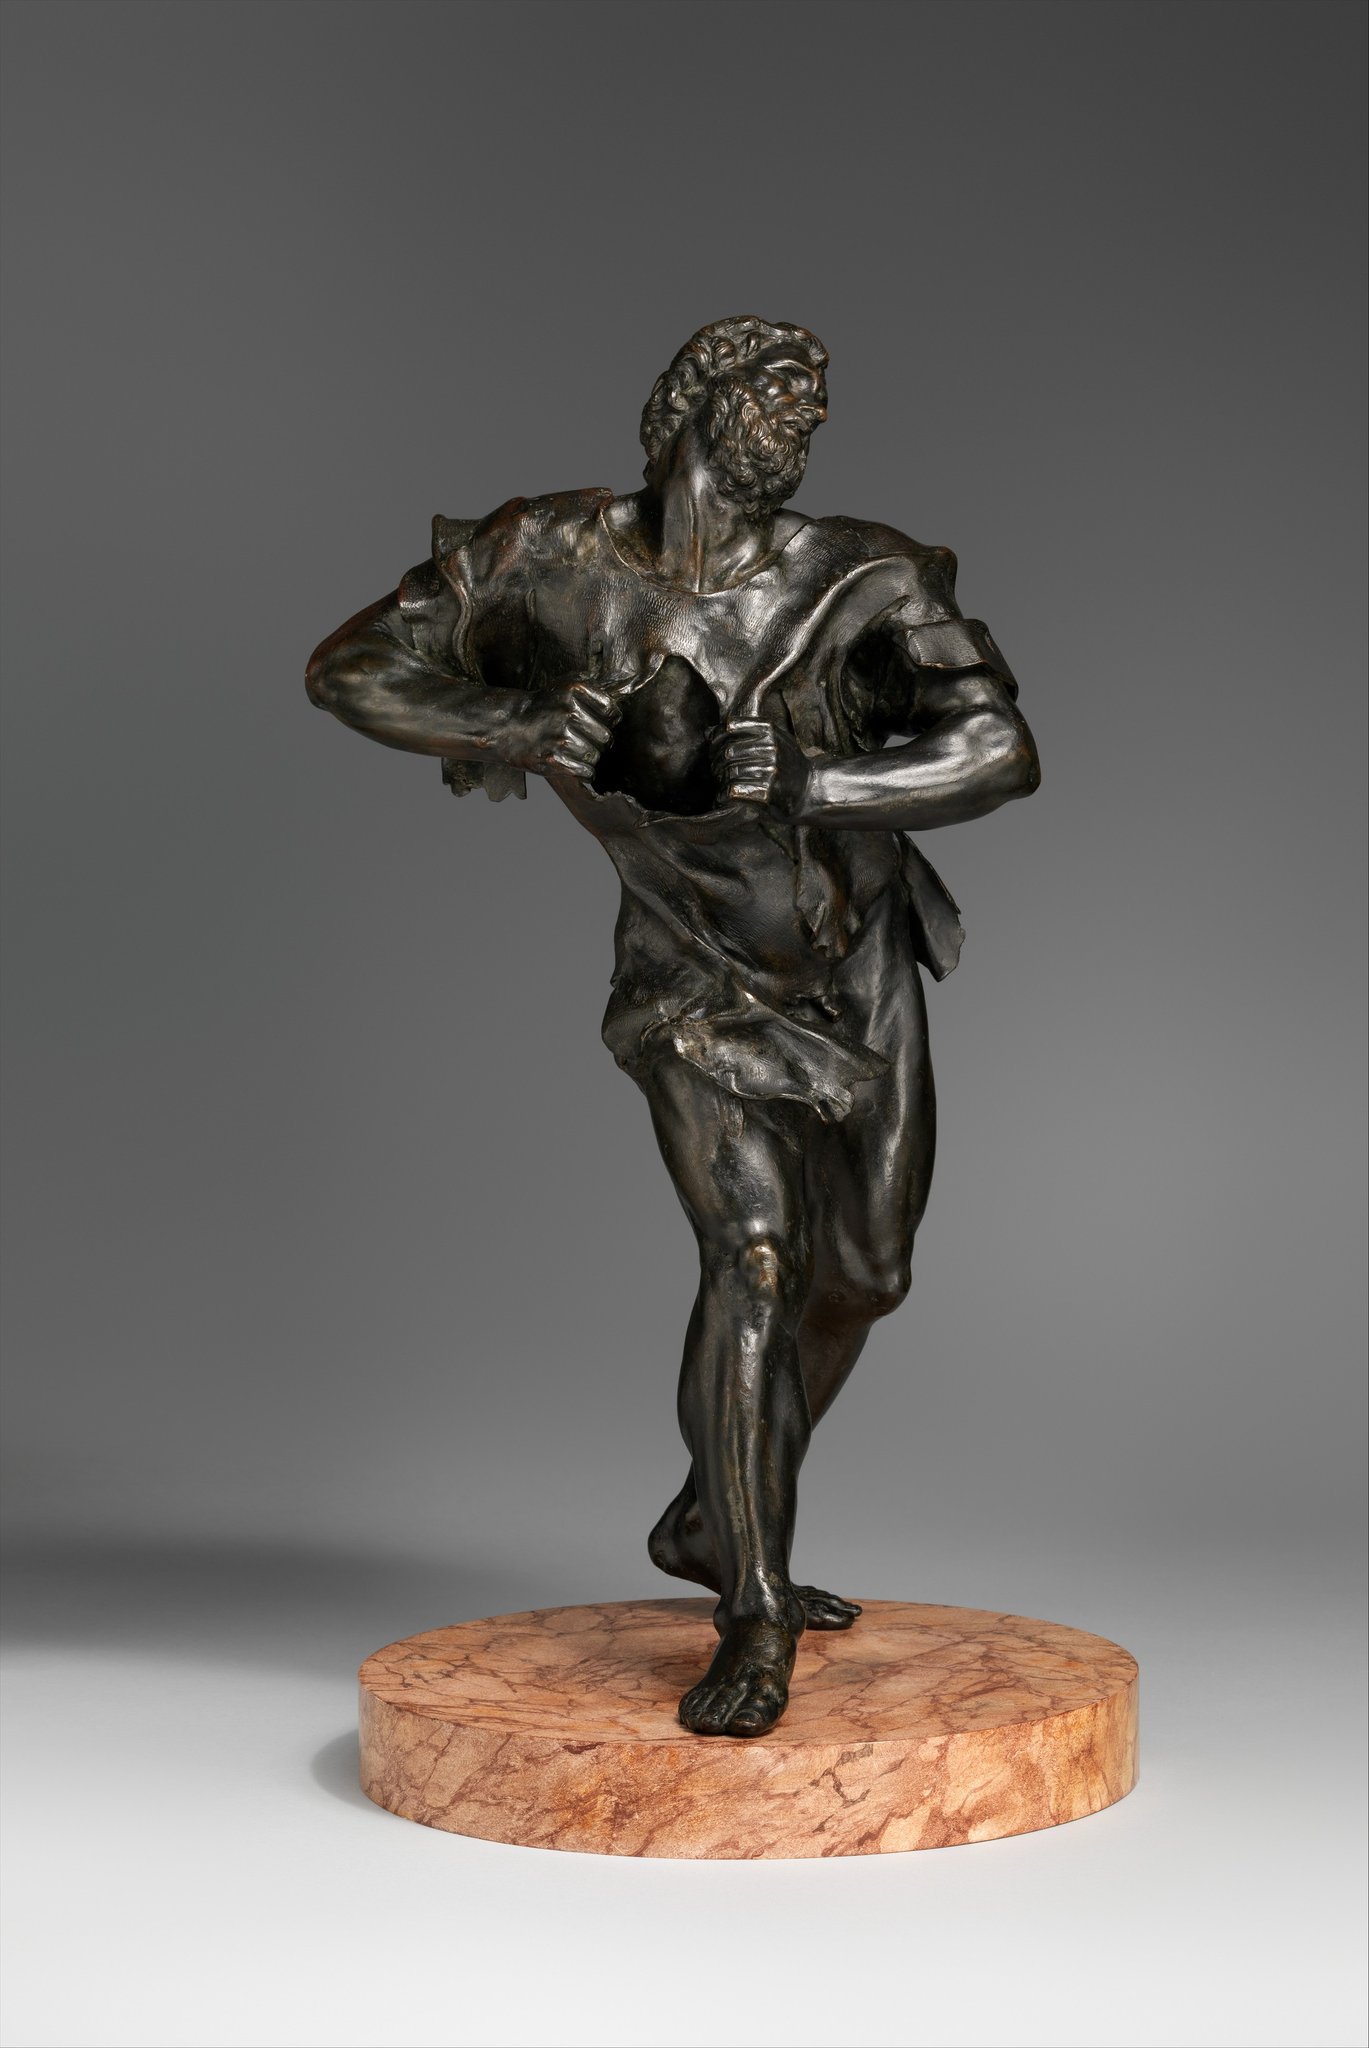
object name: statuette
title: Hercules with the Coat of Nessus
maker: unidentified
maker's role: artist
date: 1601-1700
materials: bronze, marble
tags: hercules